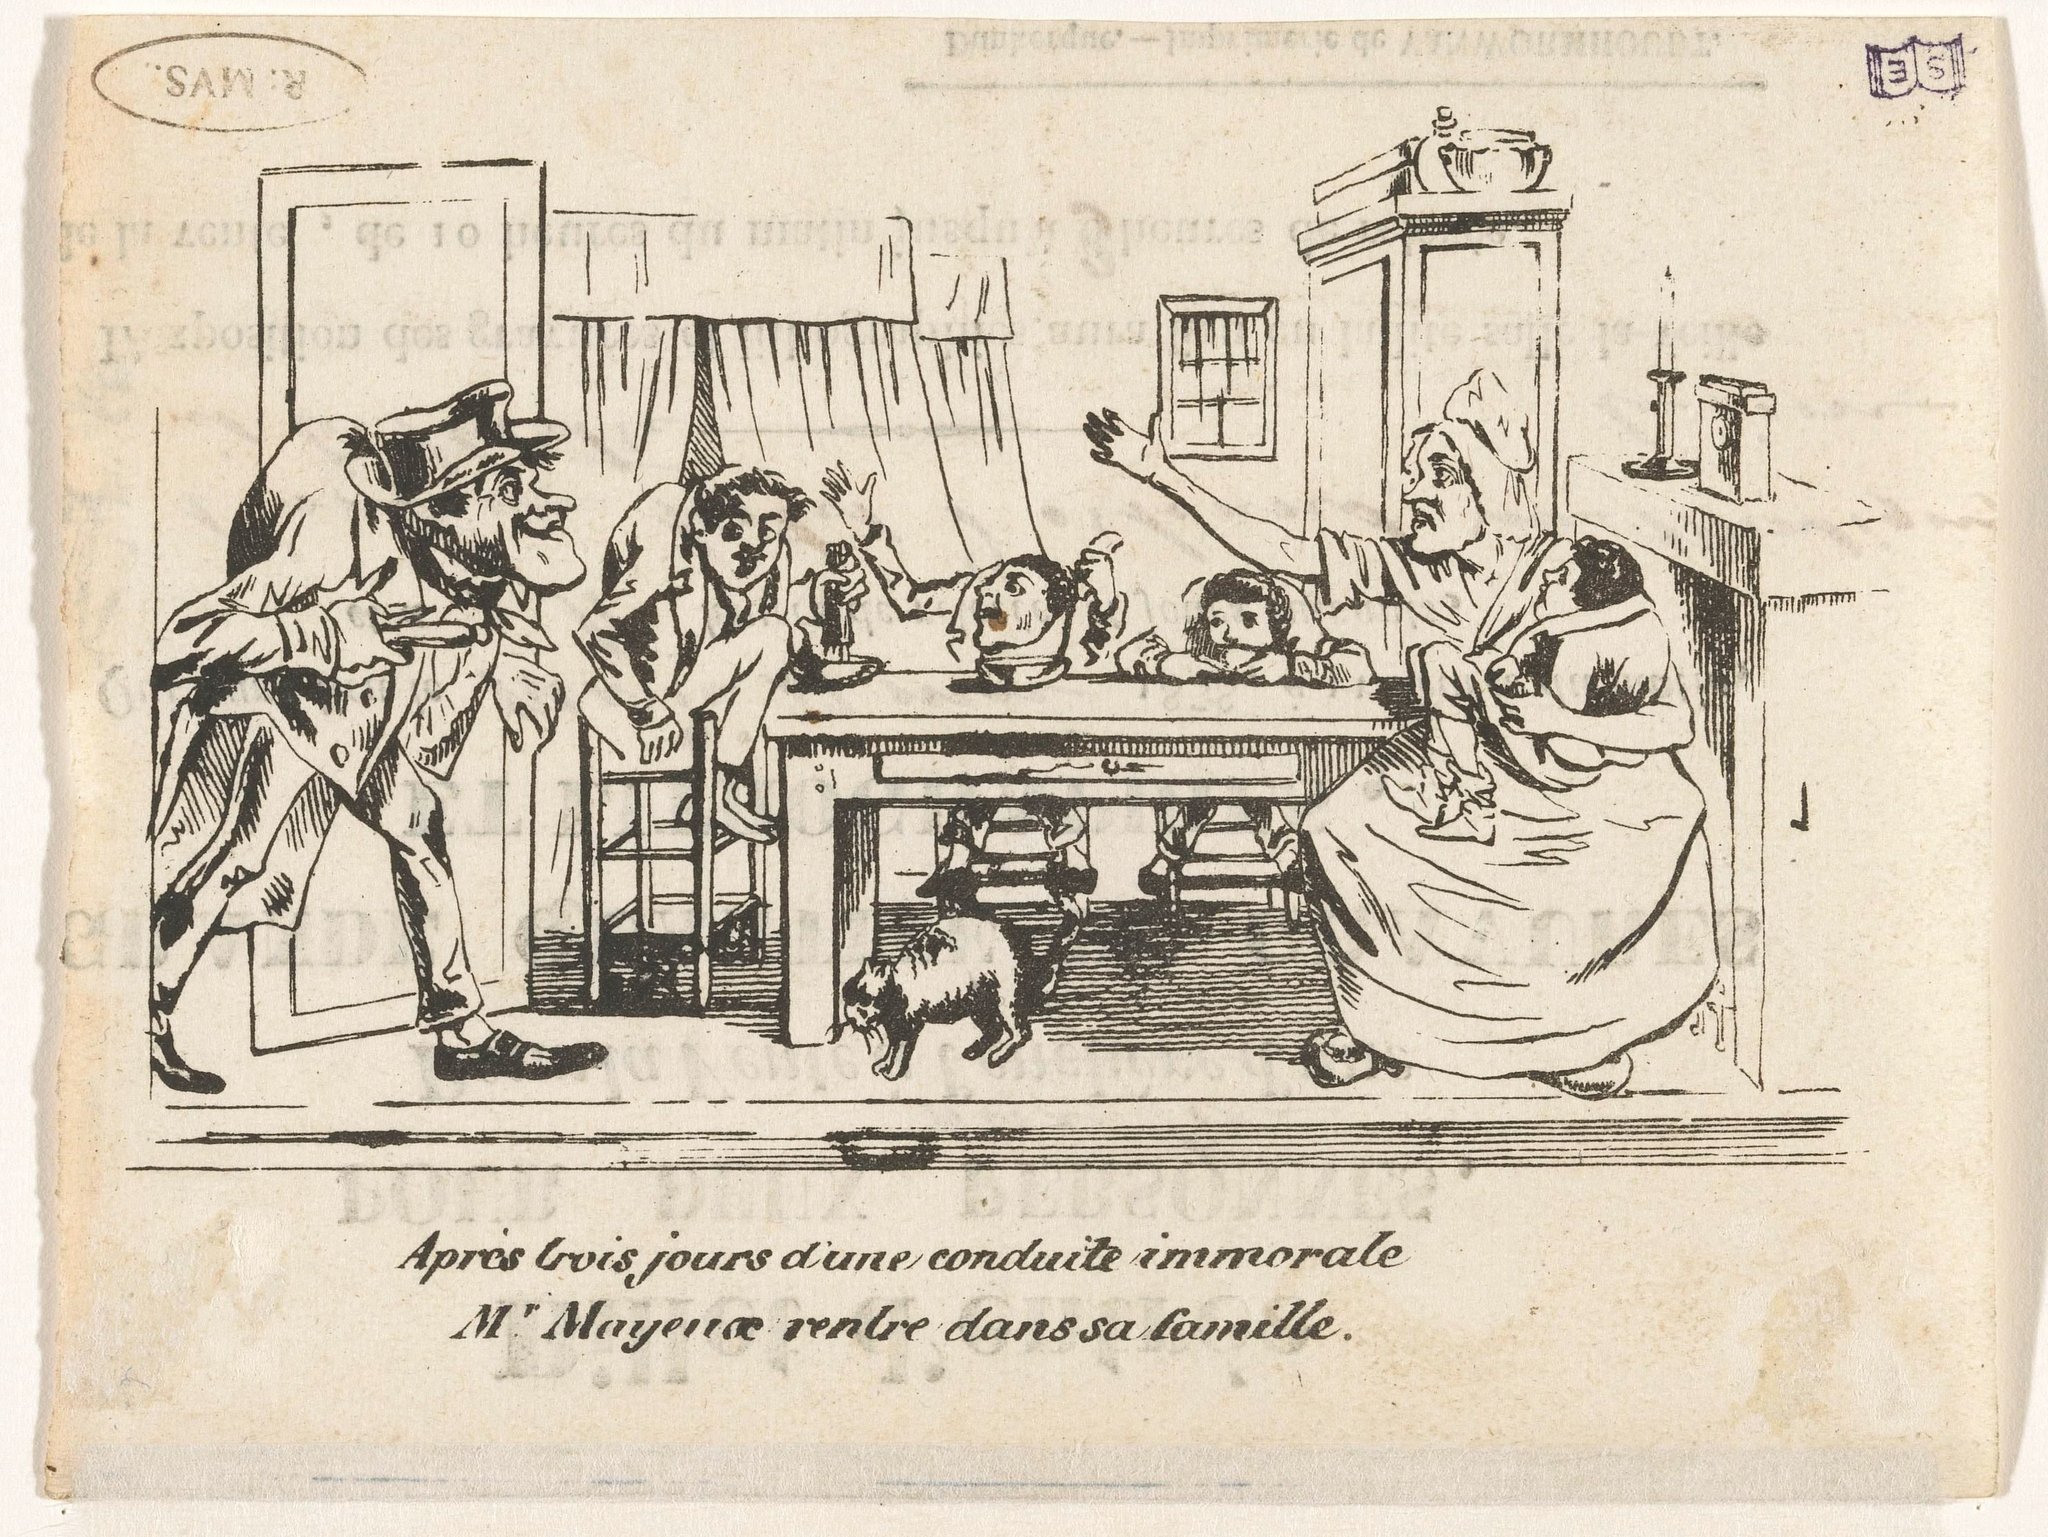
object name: print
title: Mr. Mayeux keert terug naar zijn familie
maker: Anonymous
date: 1838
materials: paper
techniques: lithograph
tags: caricatures (human types)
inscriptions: collector's mark: Lugt 4780, collector's mark: Lugt 2228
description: Interieur met een vrouw die aan tafel zit met vier kinderen, door de deuropening links komt Mr Mayeux binnen.